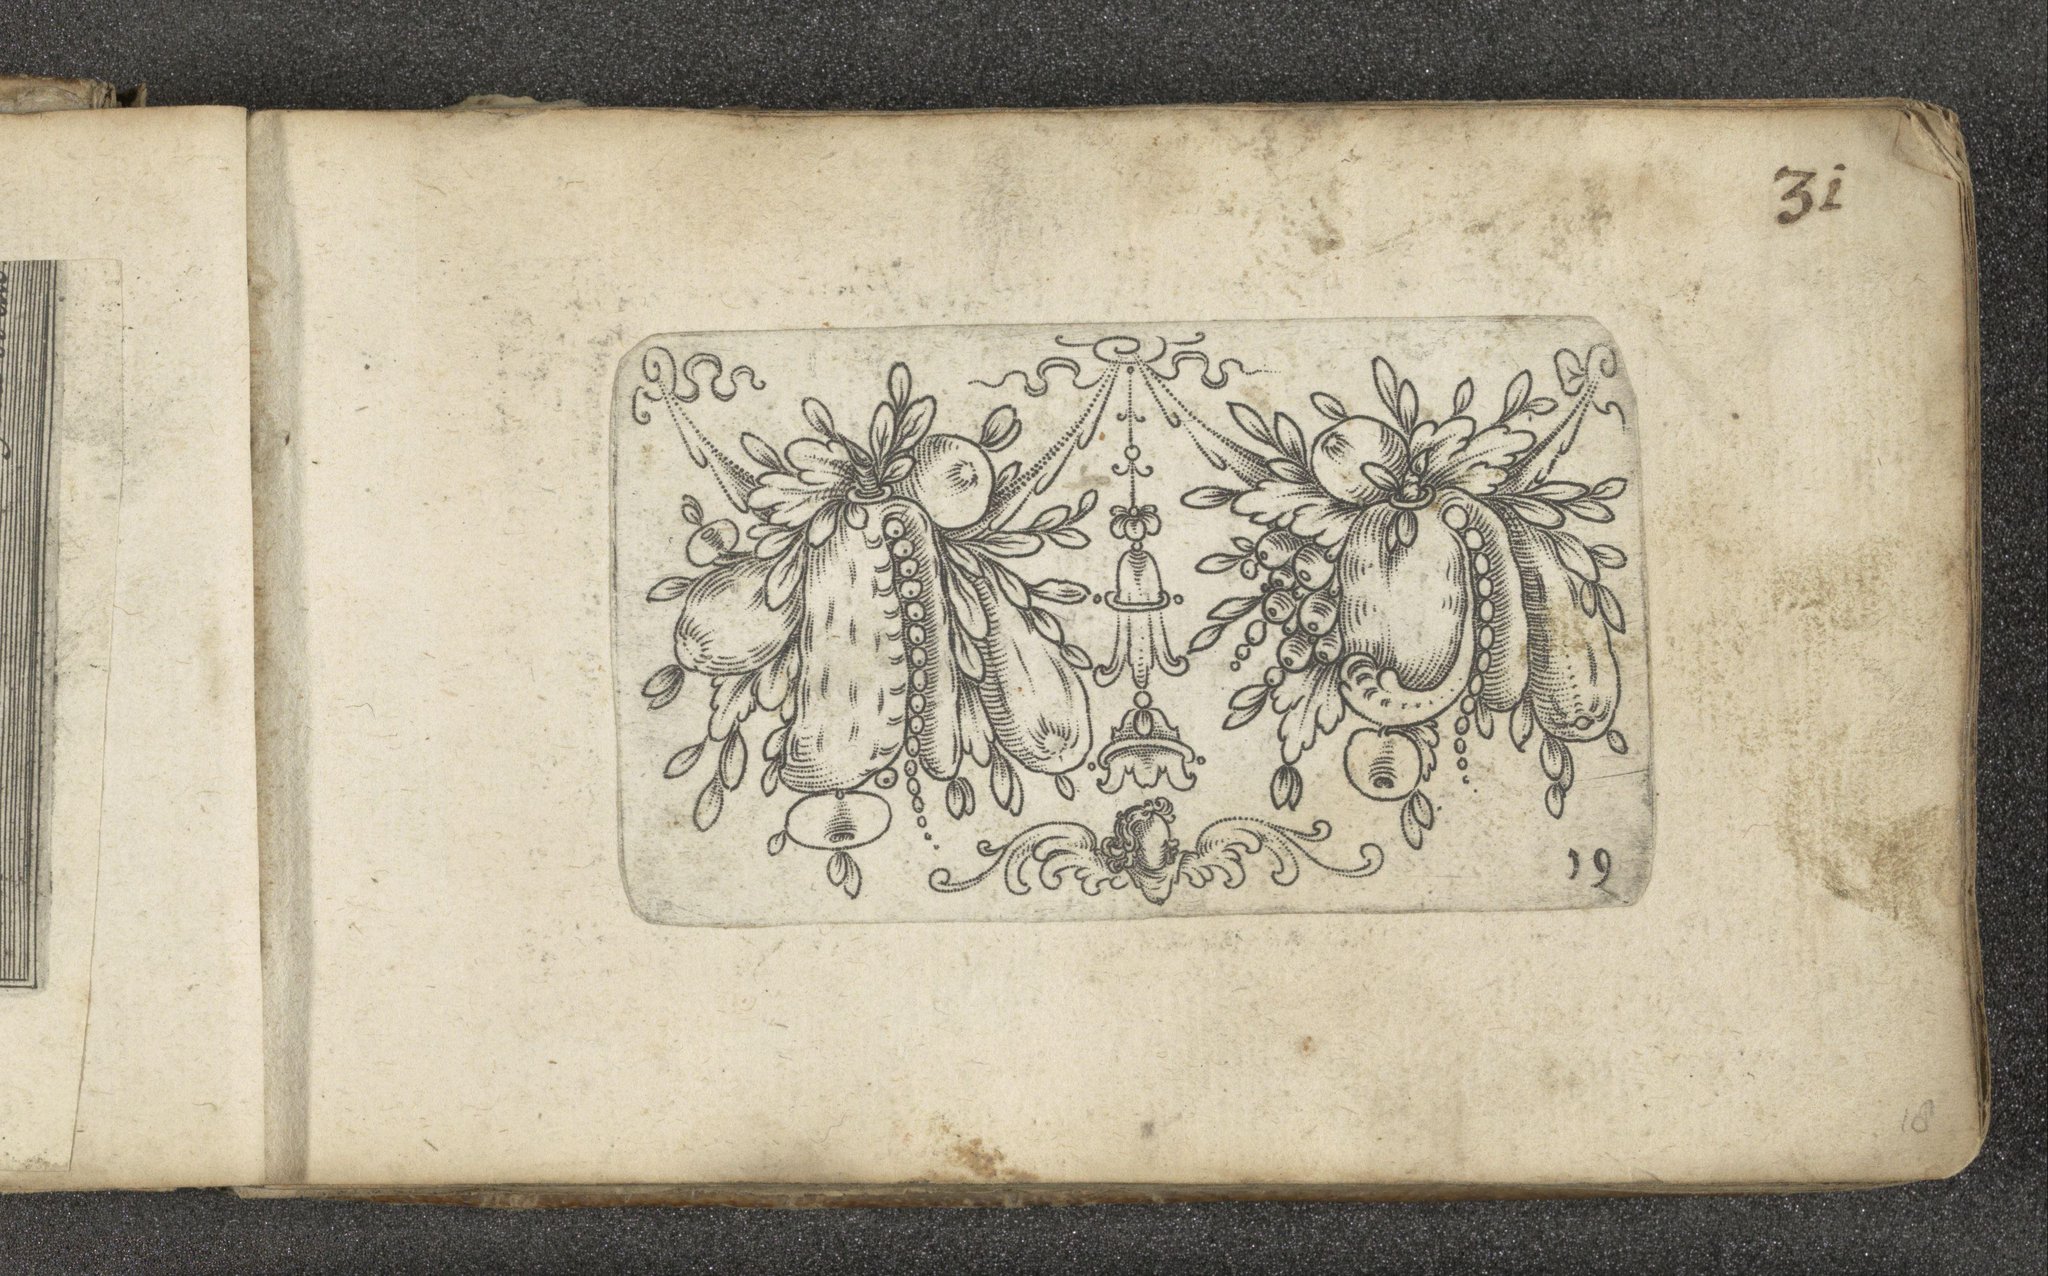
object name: album leaf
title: Twee trossen fruit en een cherubijn, in profiel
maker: Anonymous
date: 1601-1650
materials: paper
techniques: etching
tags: cherubs, i.e. children's heads with wings, ornaments ~ art, fruits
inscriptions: inscription: ‘31’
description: Twee trossen fruit en een cherubijn, in profiel. Rechtsonder genummerd: 19. De prent maakt deel uit van een album.